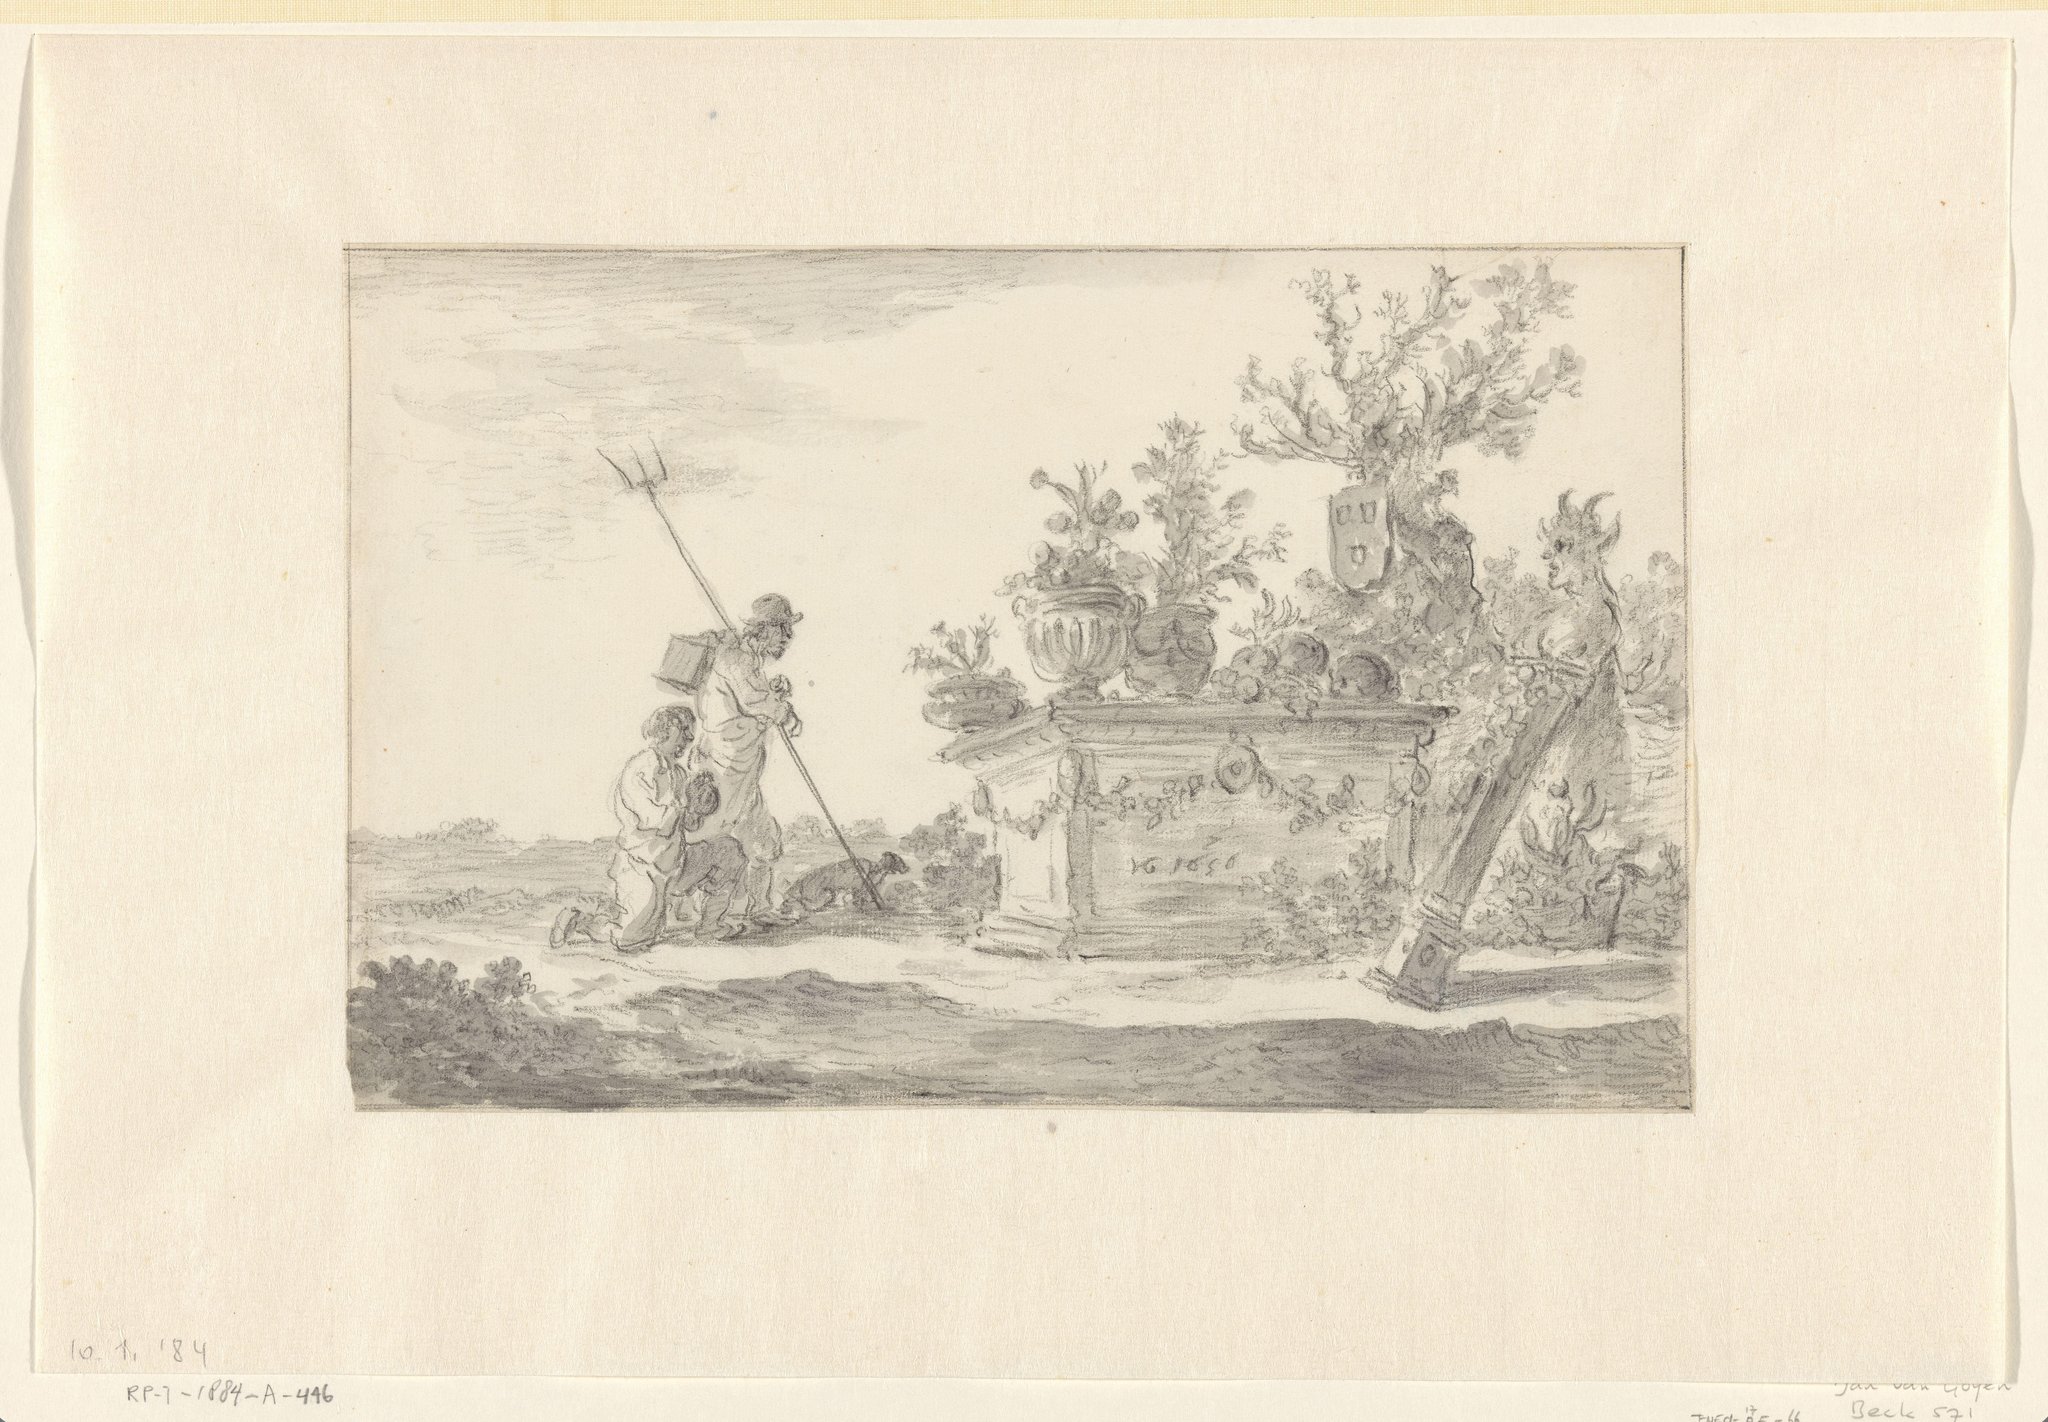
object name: design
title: Offerande aan de schilderkunst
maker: jan van goyen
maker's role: draughtsman, painter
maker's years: 1596-1656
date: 1656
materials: chalk, paper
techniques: brush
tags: coat of arms of guild of st. luke, altar ~ non-christian religions - bb - in the open air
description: Twee mannen in aanbidding voor een altaar waarop enige bloemvazen staan. Naast het altaar een omgevallen zuil met een buste van een faun; op een boom het wapen van de St. Lukas-gilde. Mogelijk een ontwerp voor een titelblad.